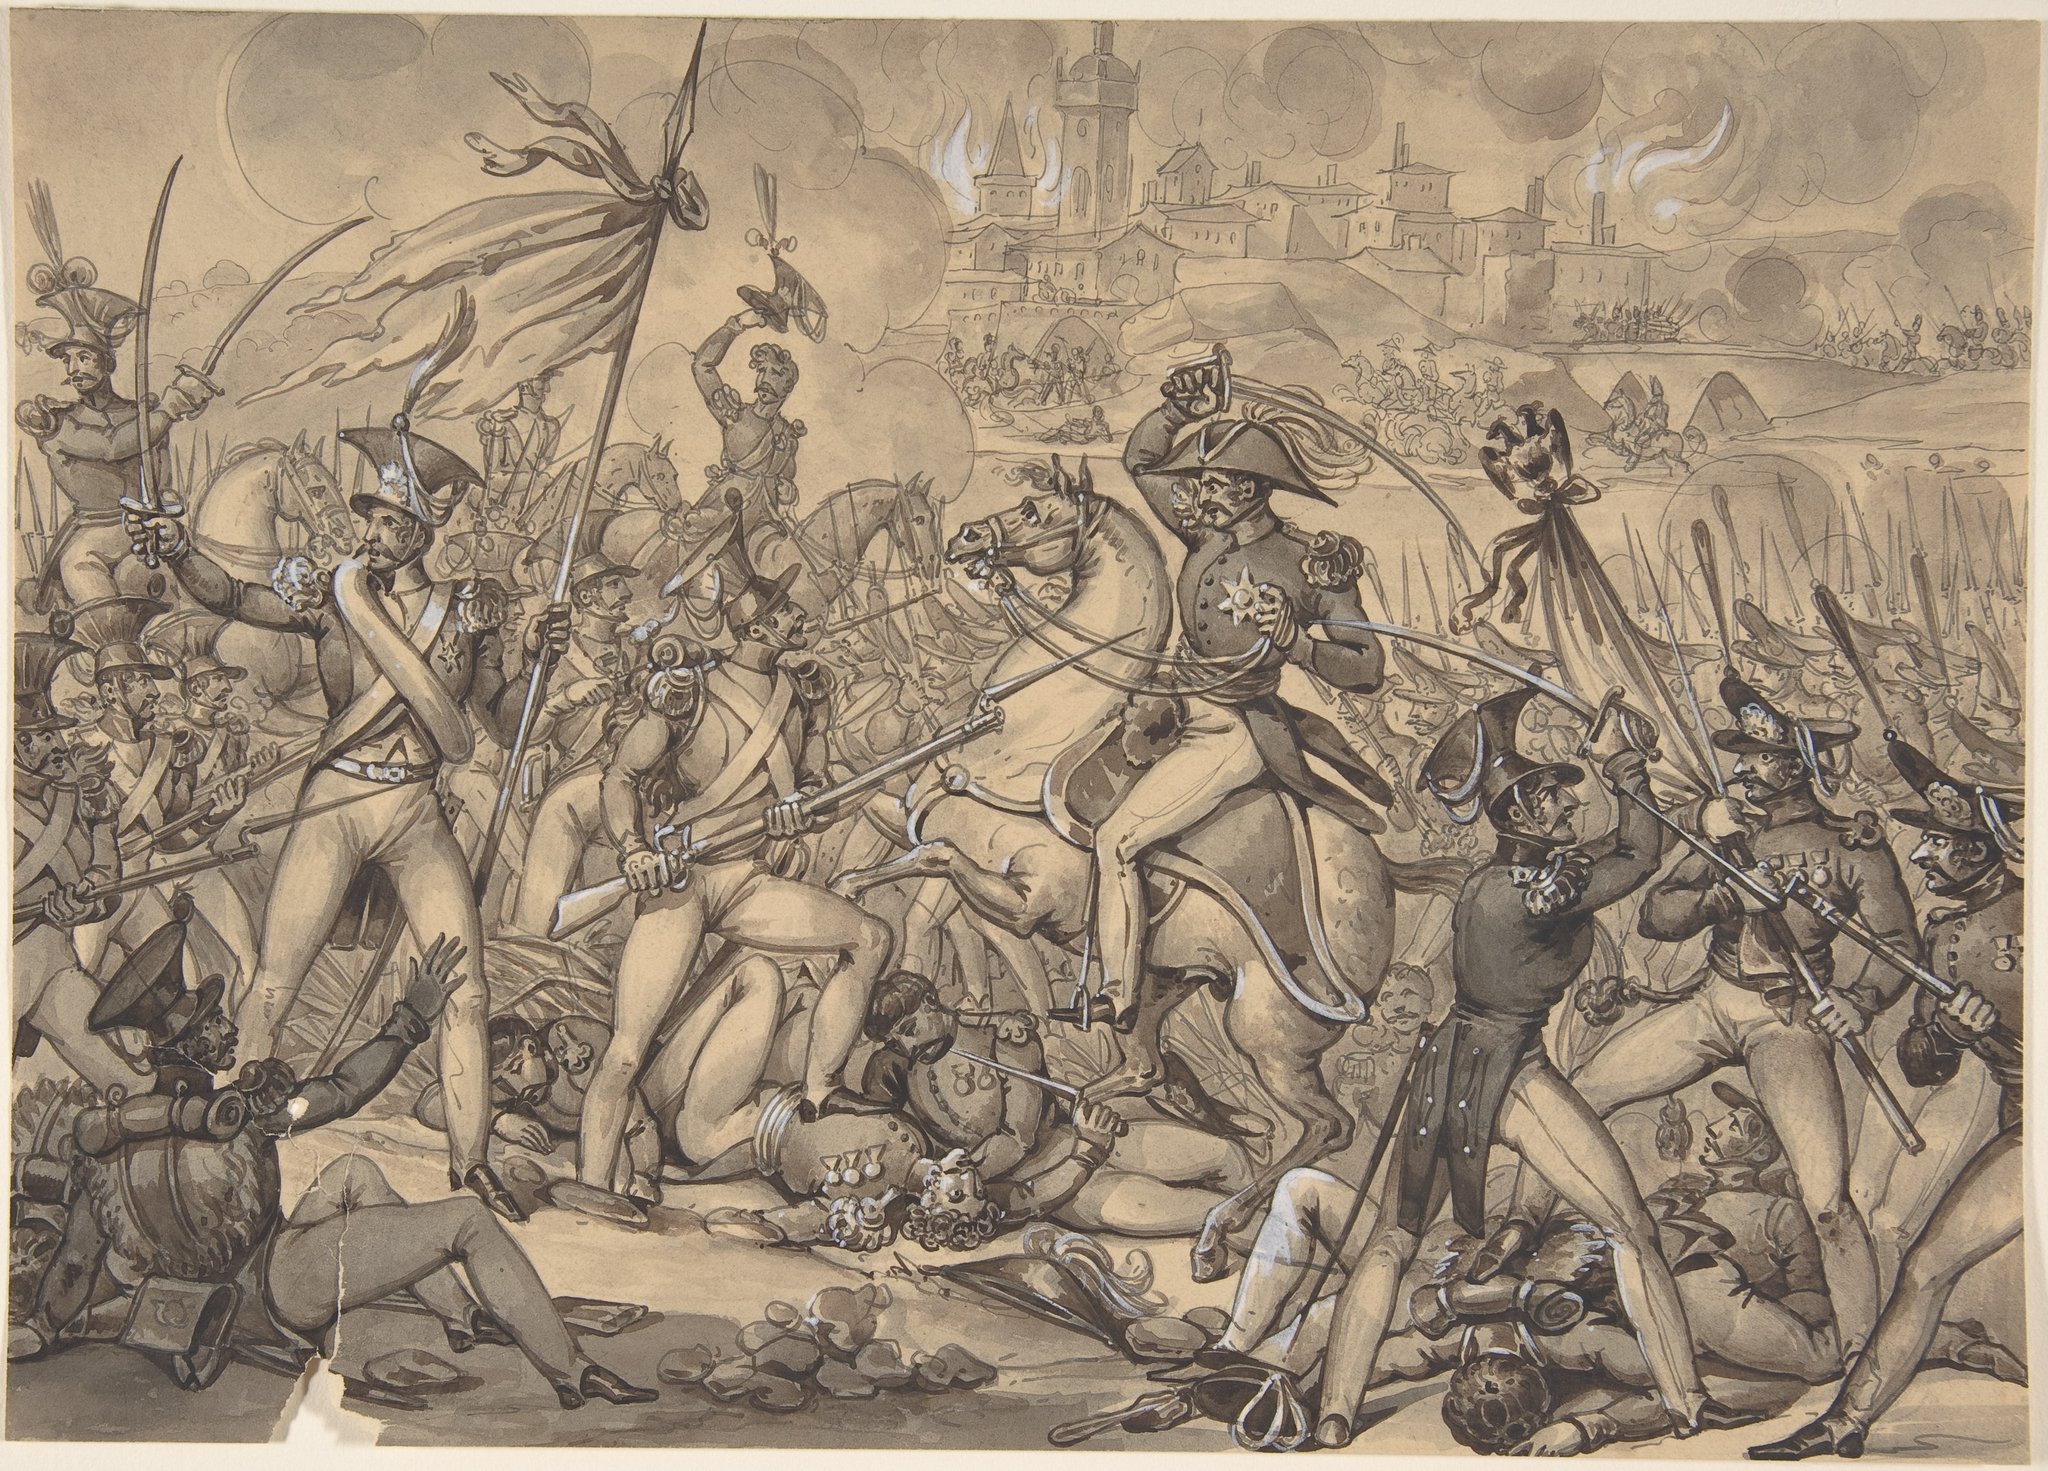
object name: drawing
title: The Battle of ?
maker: anonymous, french, 19th century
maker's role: artist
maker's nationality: french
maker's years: 1800-1900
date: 1801-1900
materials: graphite, ink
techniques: brush, pen, wash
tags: battles,soldiers,weapons,horses